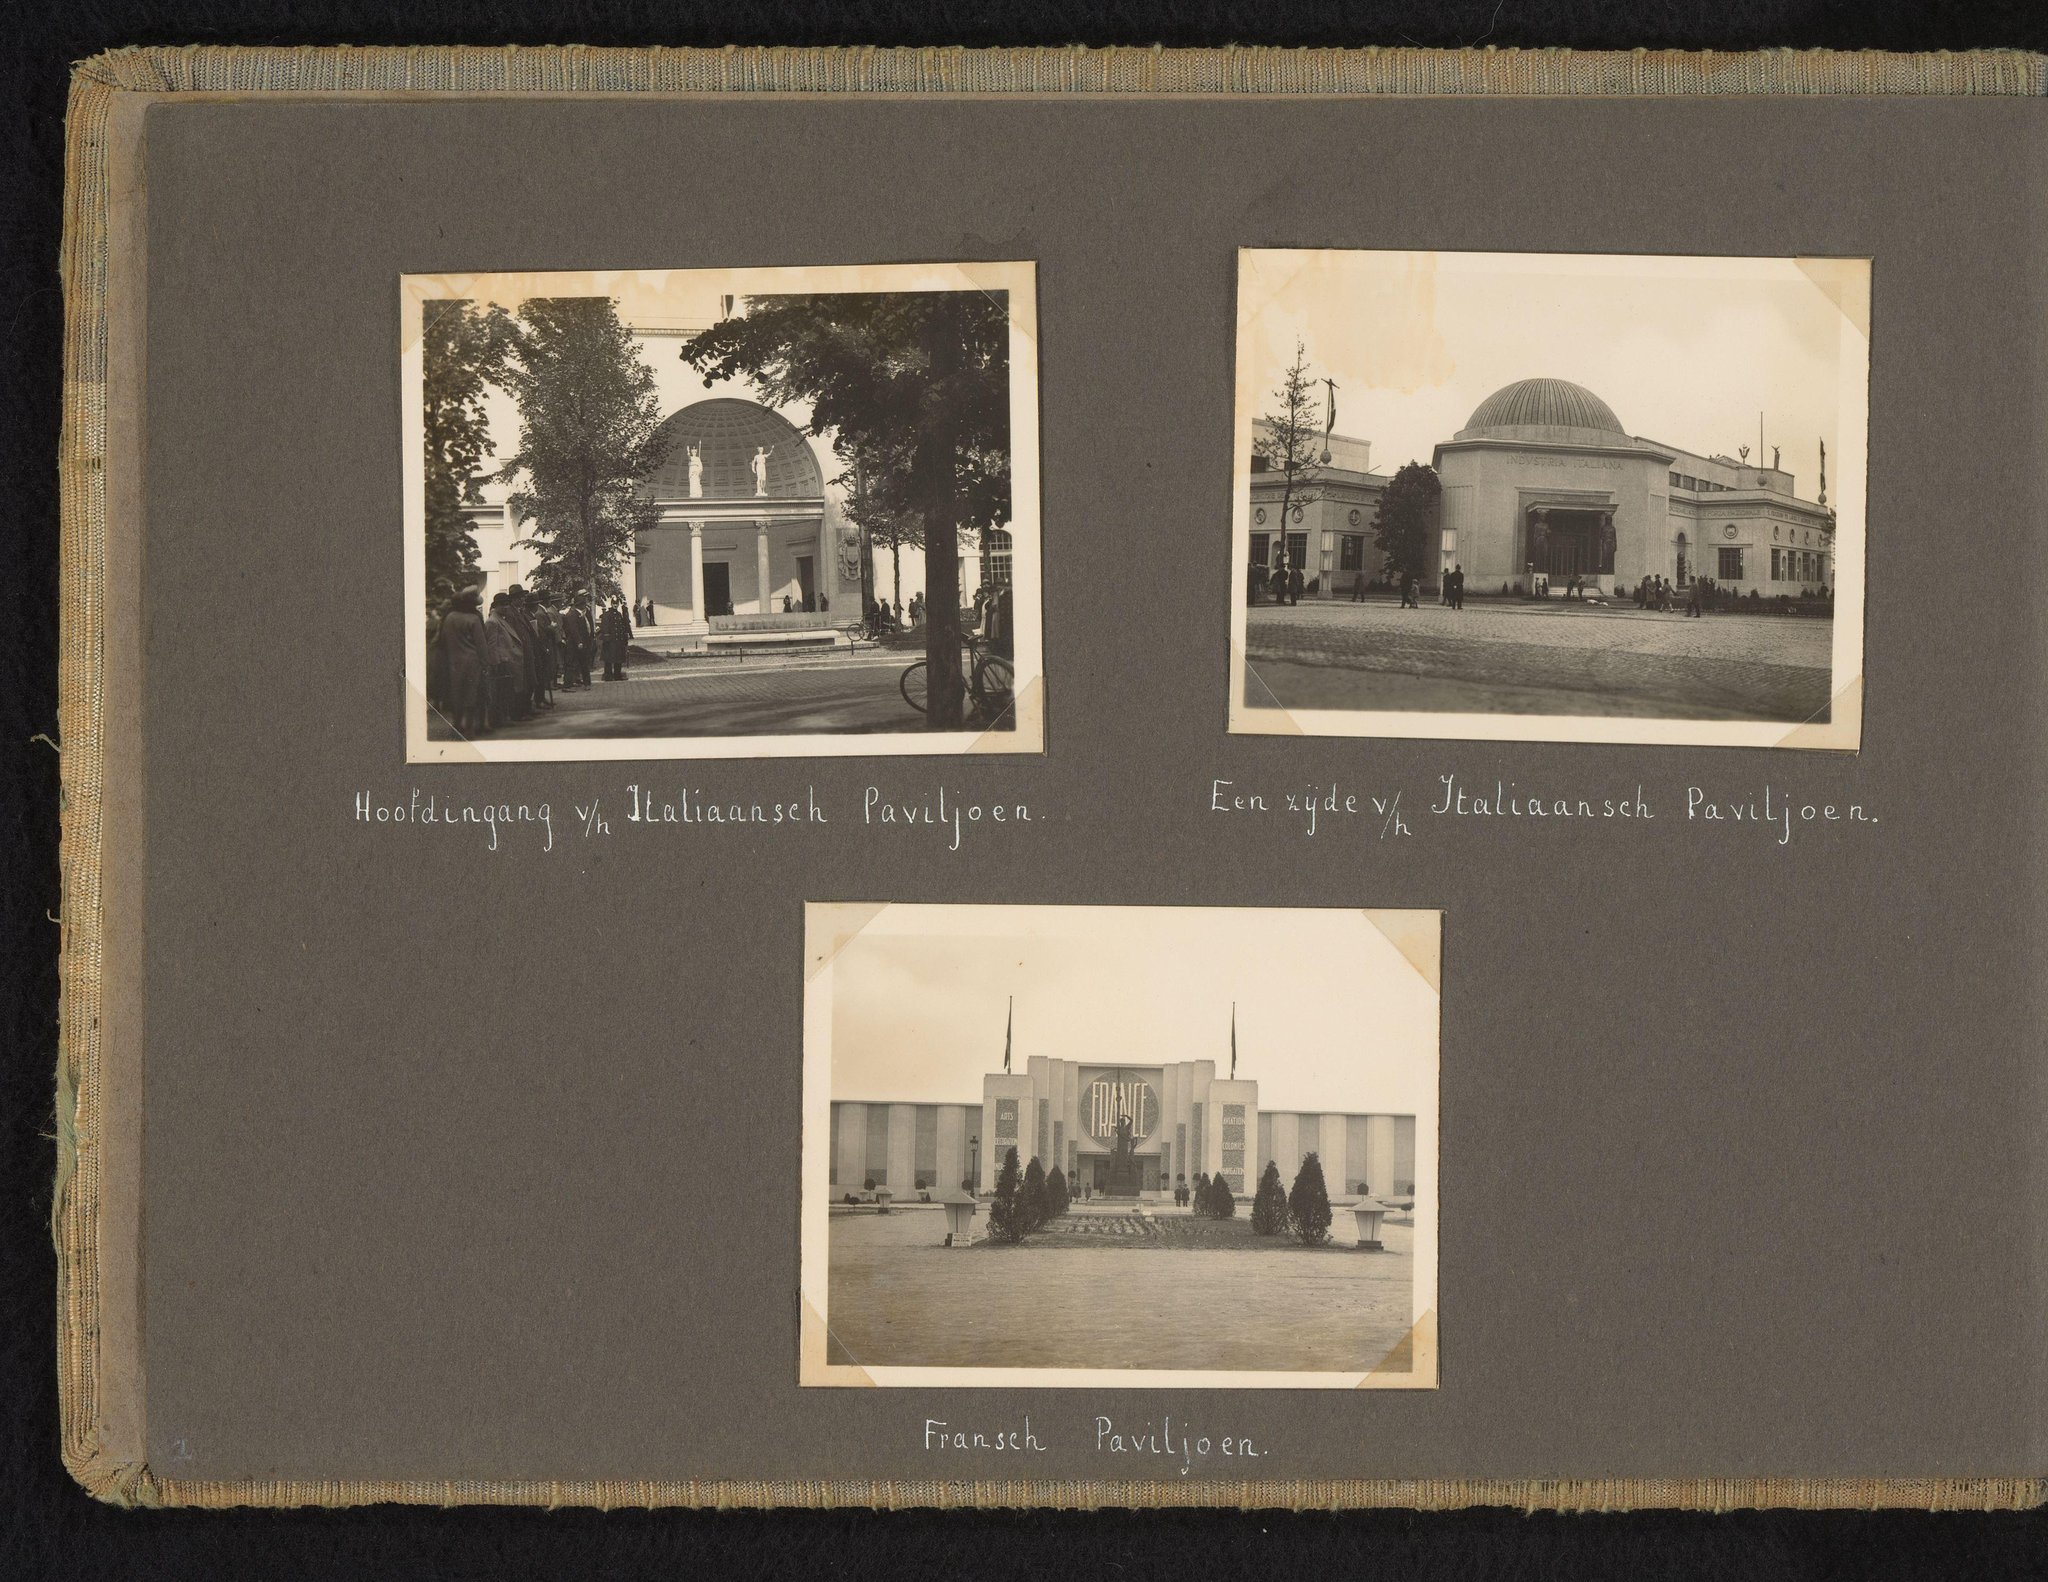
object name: photograph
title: Bezoek aan de Wereldtentoonstelling te Antwerpen, oktober 1930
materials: cardboard, photographic support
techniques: gelatin silver print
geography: antwerp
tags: world fair, world exhibition, outing, pleasure trip, student life, antwerp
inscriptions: inscription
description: Albumblad met drie foto's van een bezoek aan verschillende paviljoens op de Wereldtentoonstelling te Antwerpen in 1930. Onderdeel van fotoalbum 'Studentenalbum Indologen'.